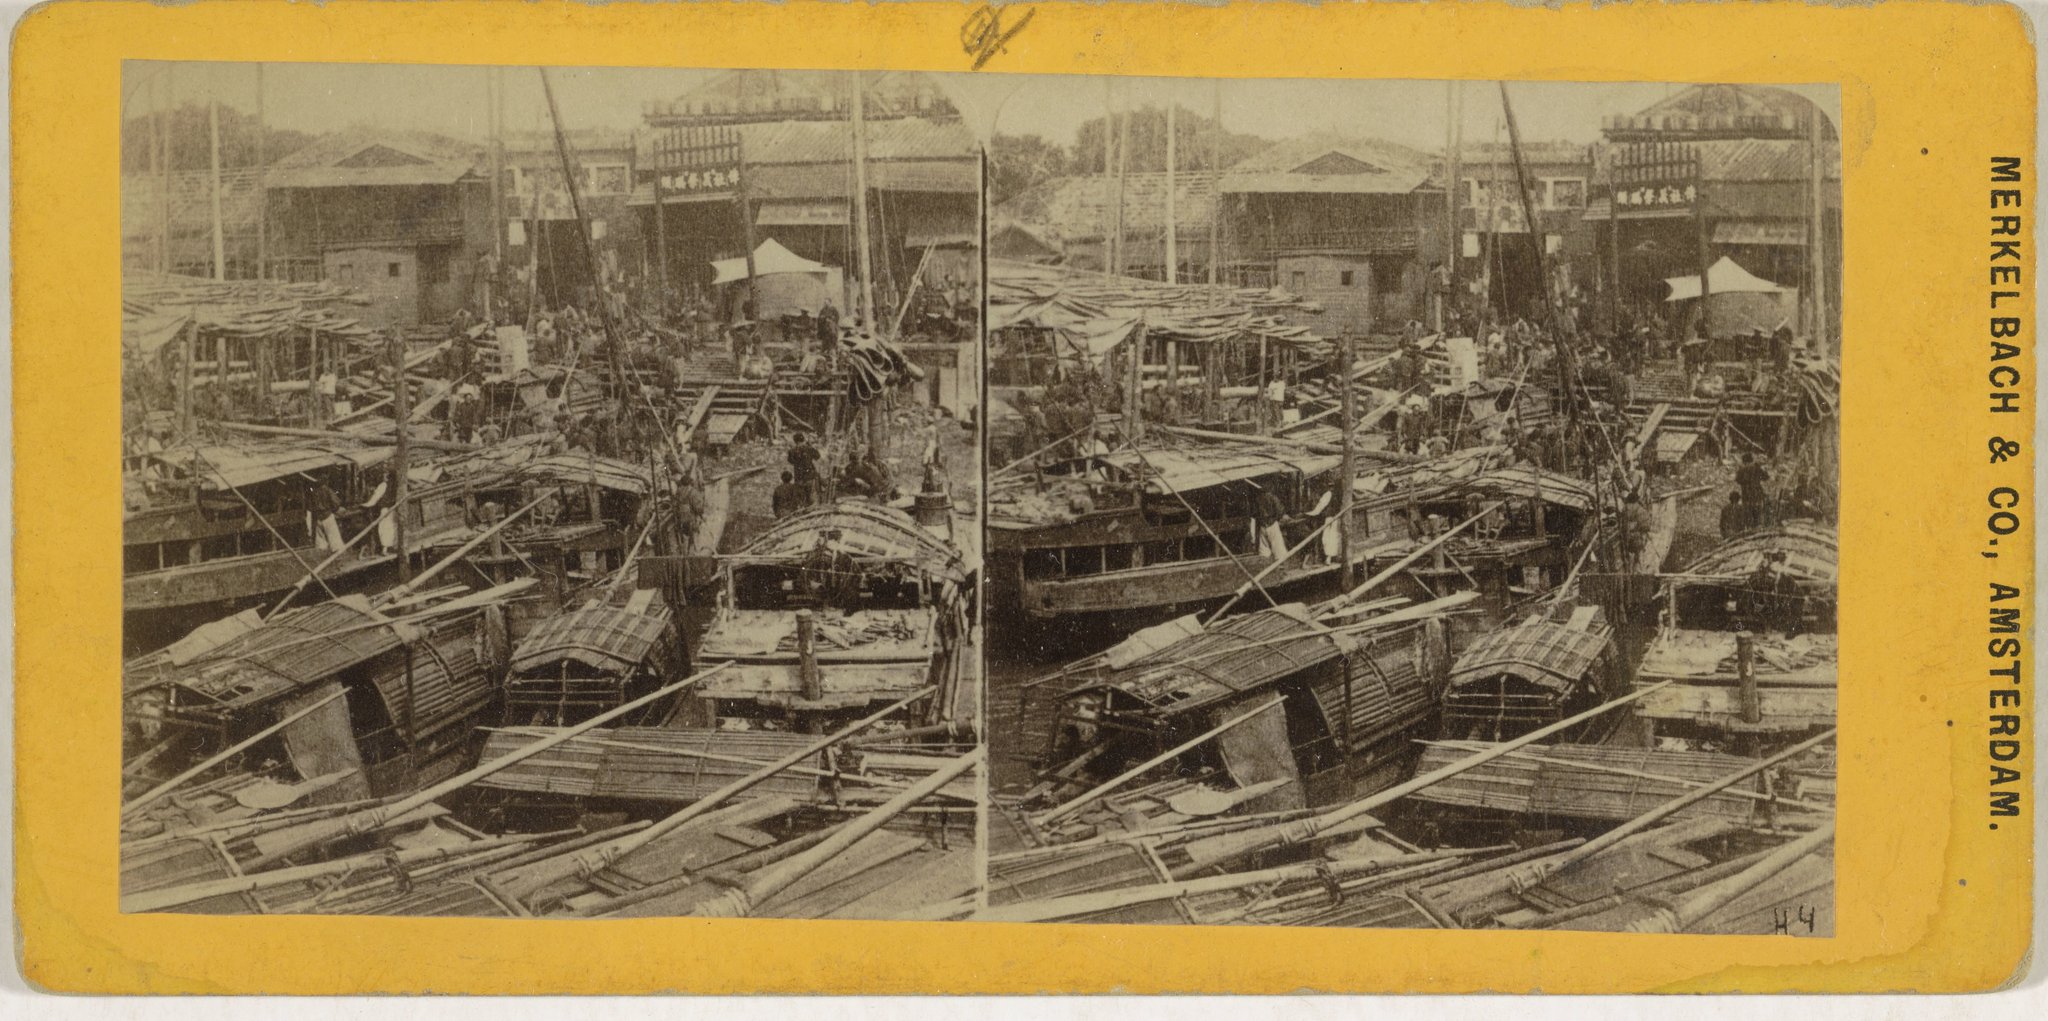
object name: stereograph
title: Aardrijkskundige beeldengalerij, verzameld door M.J. Broekhuijsen, hoofd eener school te Amsterdam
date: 1900-1902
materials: cardboard, paper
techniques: albumen print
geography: amsterdam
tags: harbour, ships (in general) - cc - more than one ship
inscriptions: inscription: ‘Een deel van China is zóó dicht bevolkt, dat zelfs op het water (...)’, number: ‘4’, inscription: ‘H 4’